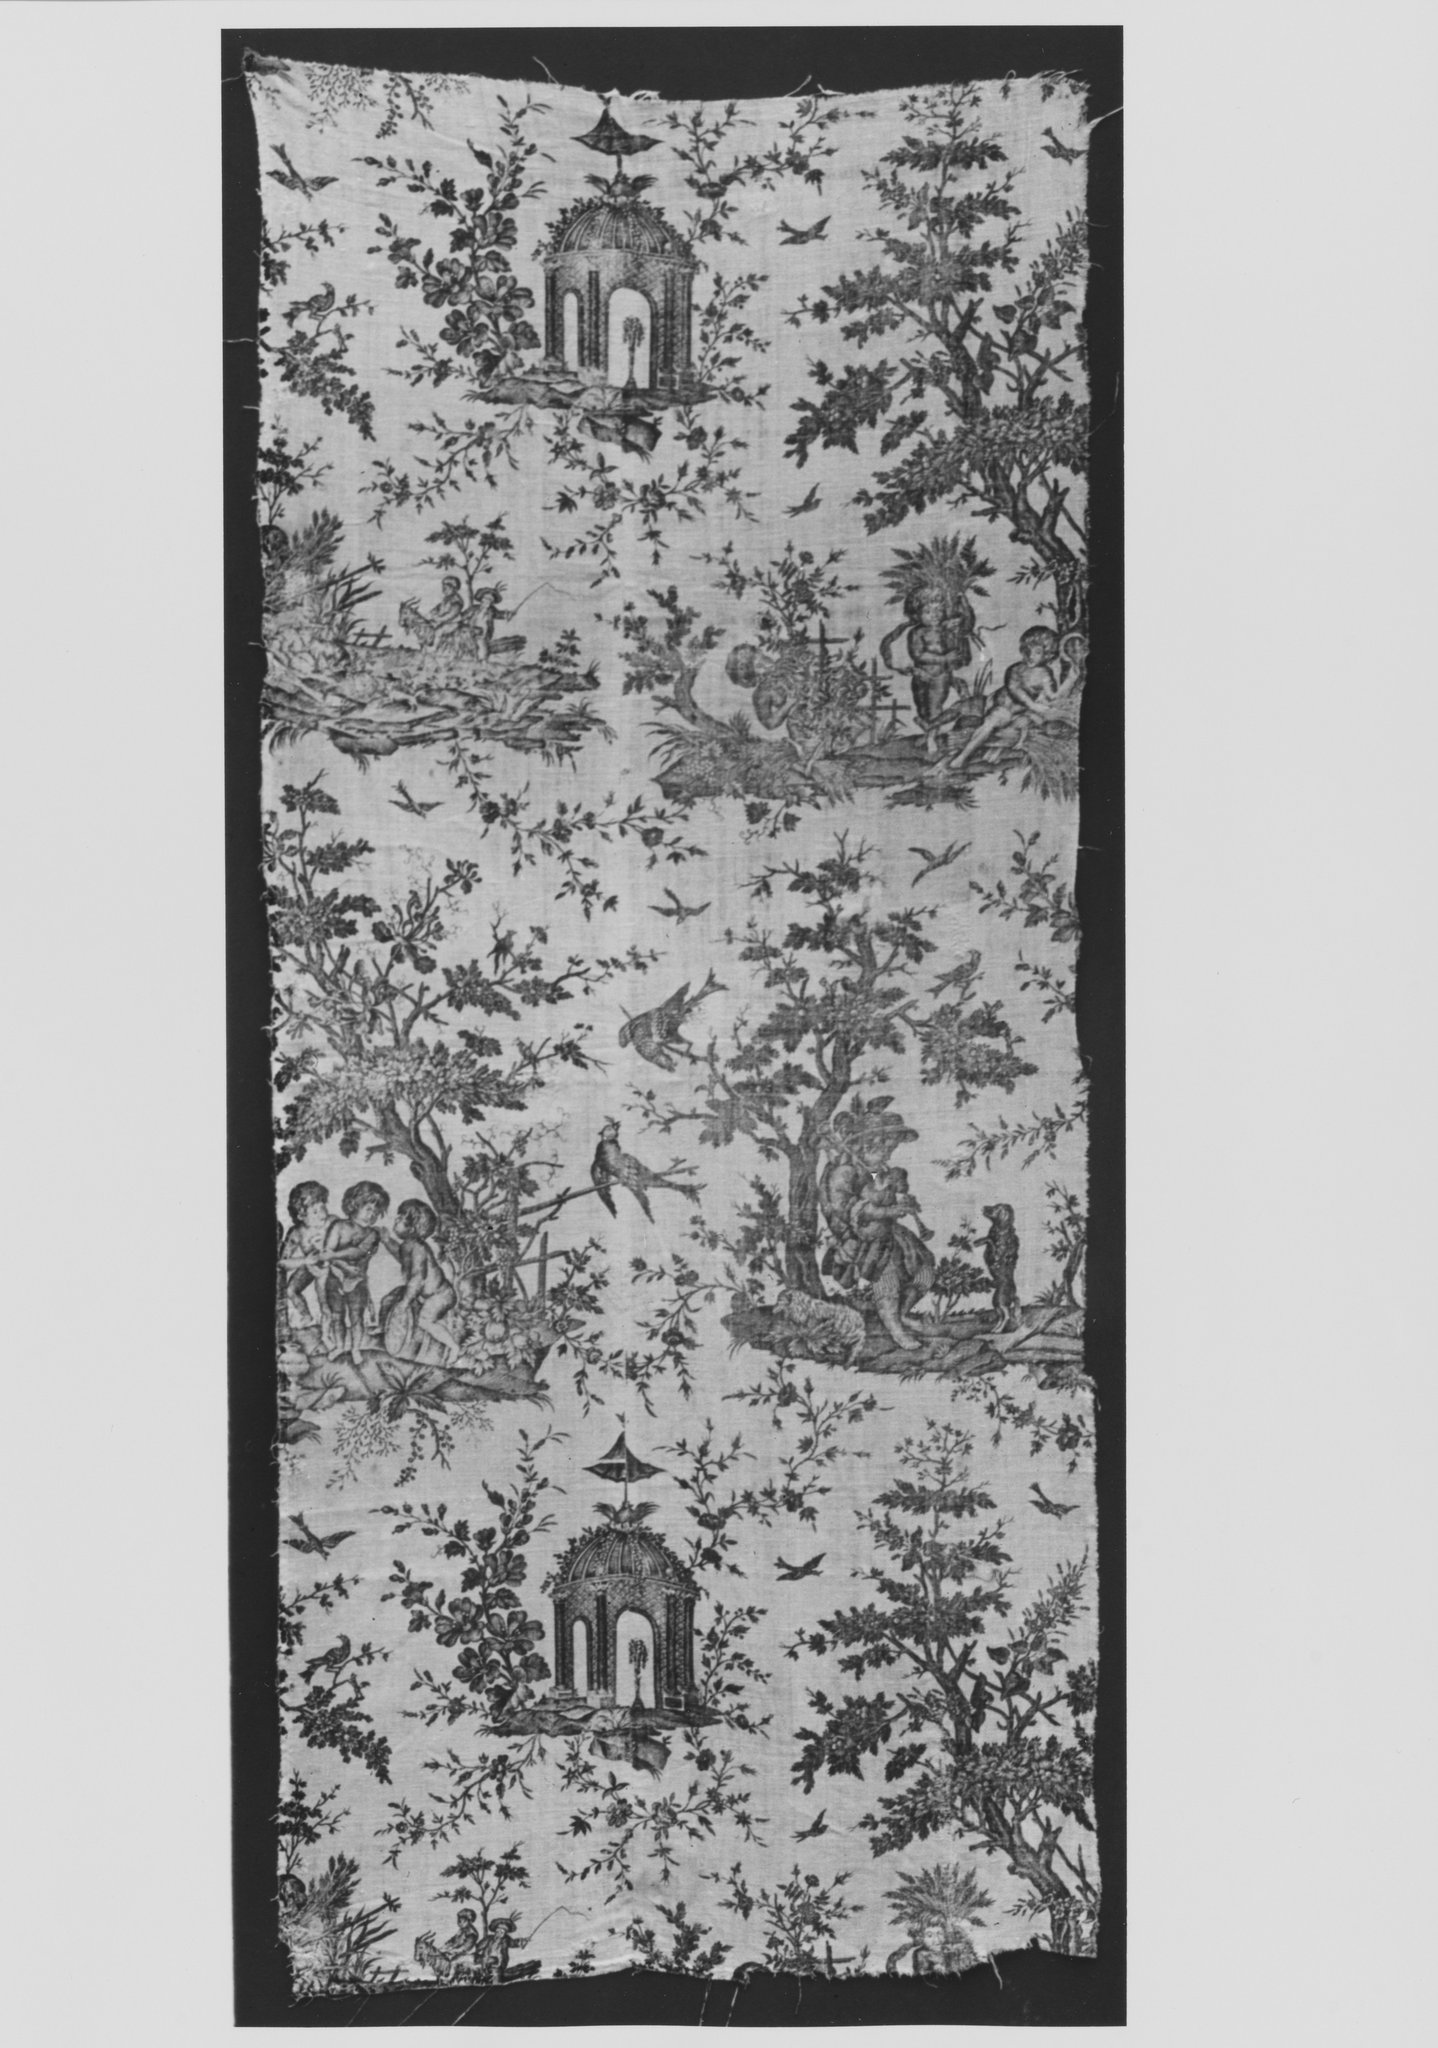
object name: piece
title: "Vintage Scenes"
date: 1701-1800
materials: cotton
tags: musical instruments,birds,children,dogs